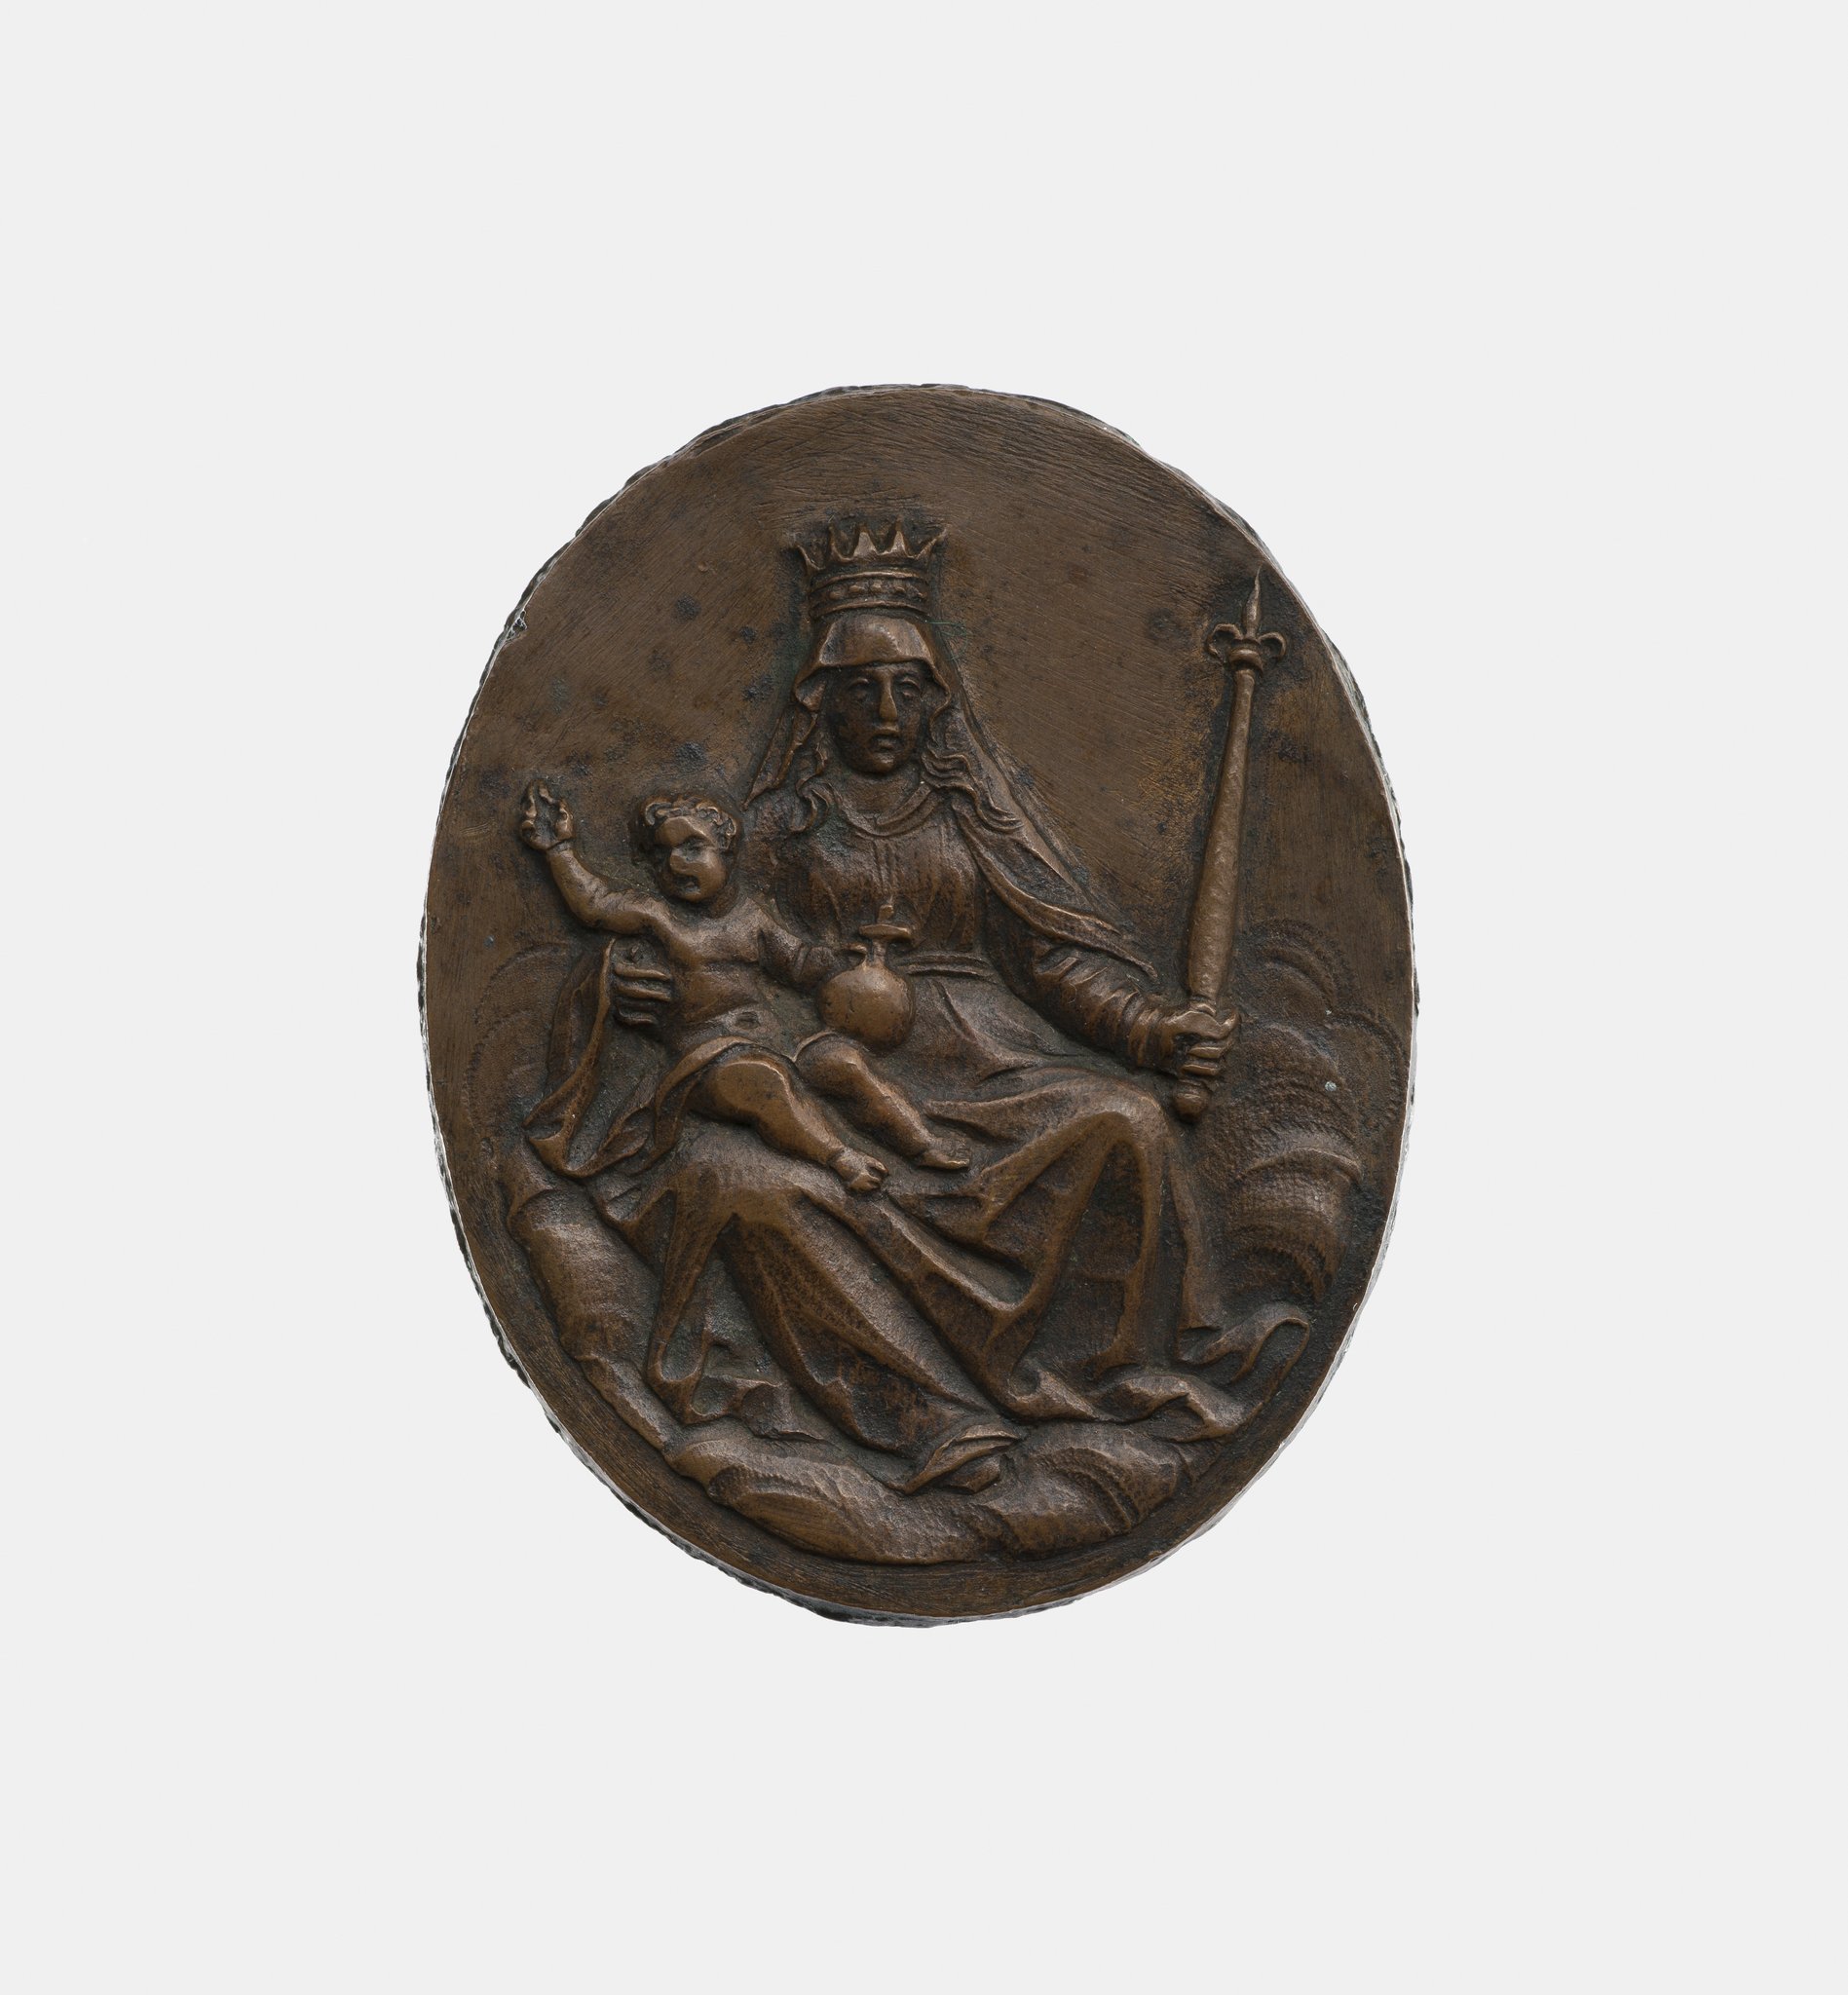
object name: plaquette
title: Madonna and child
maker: Anonymous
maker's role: artist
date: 1701-1800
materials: bronze